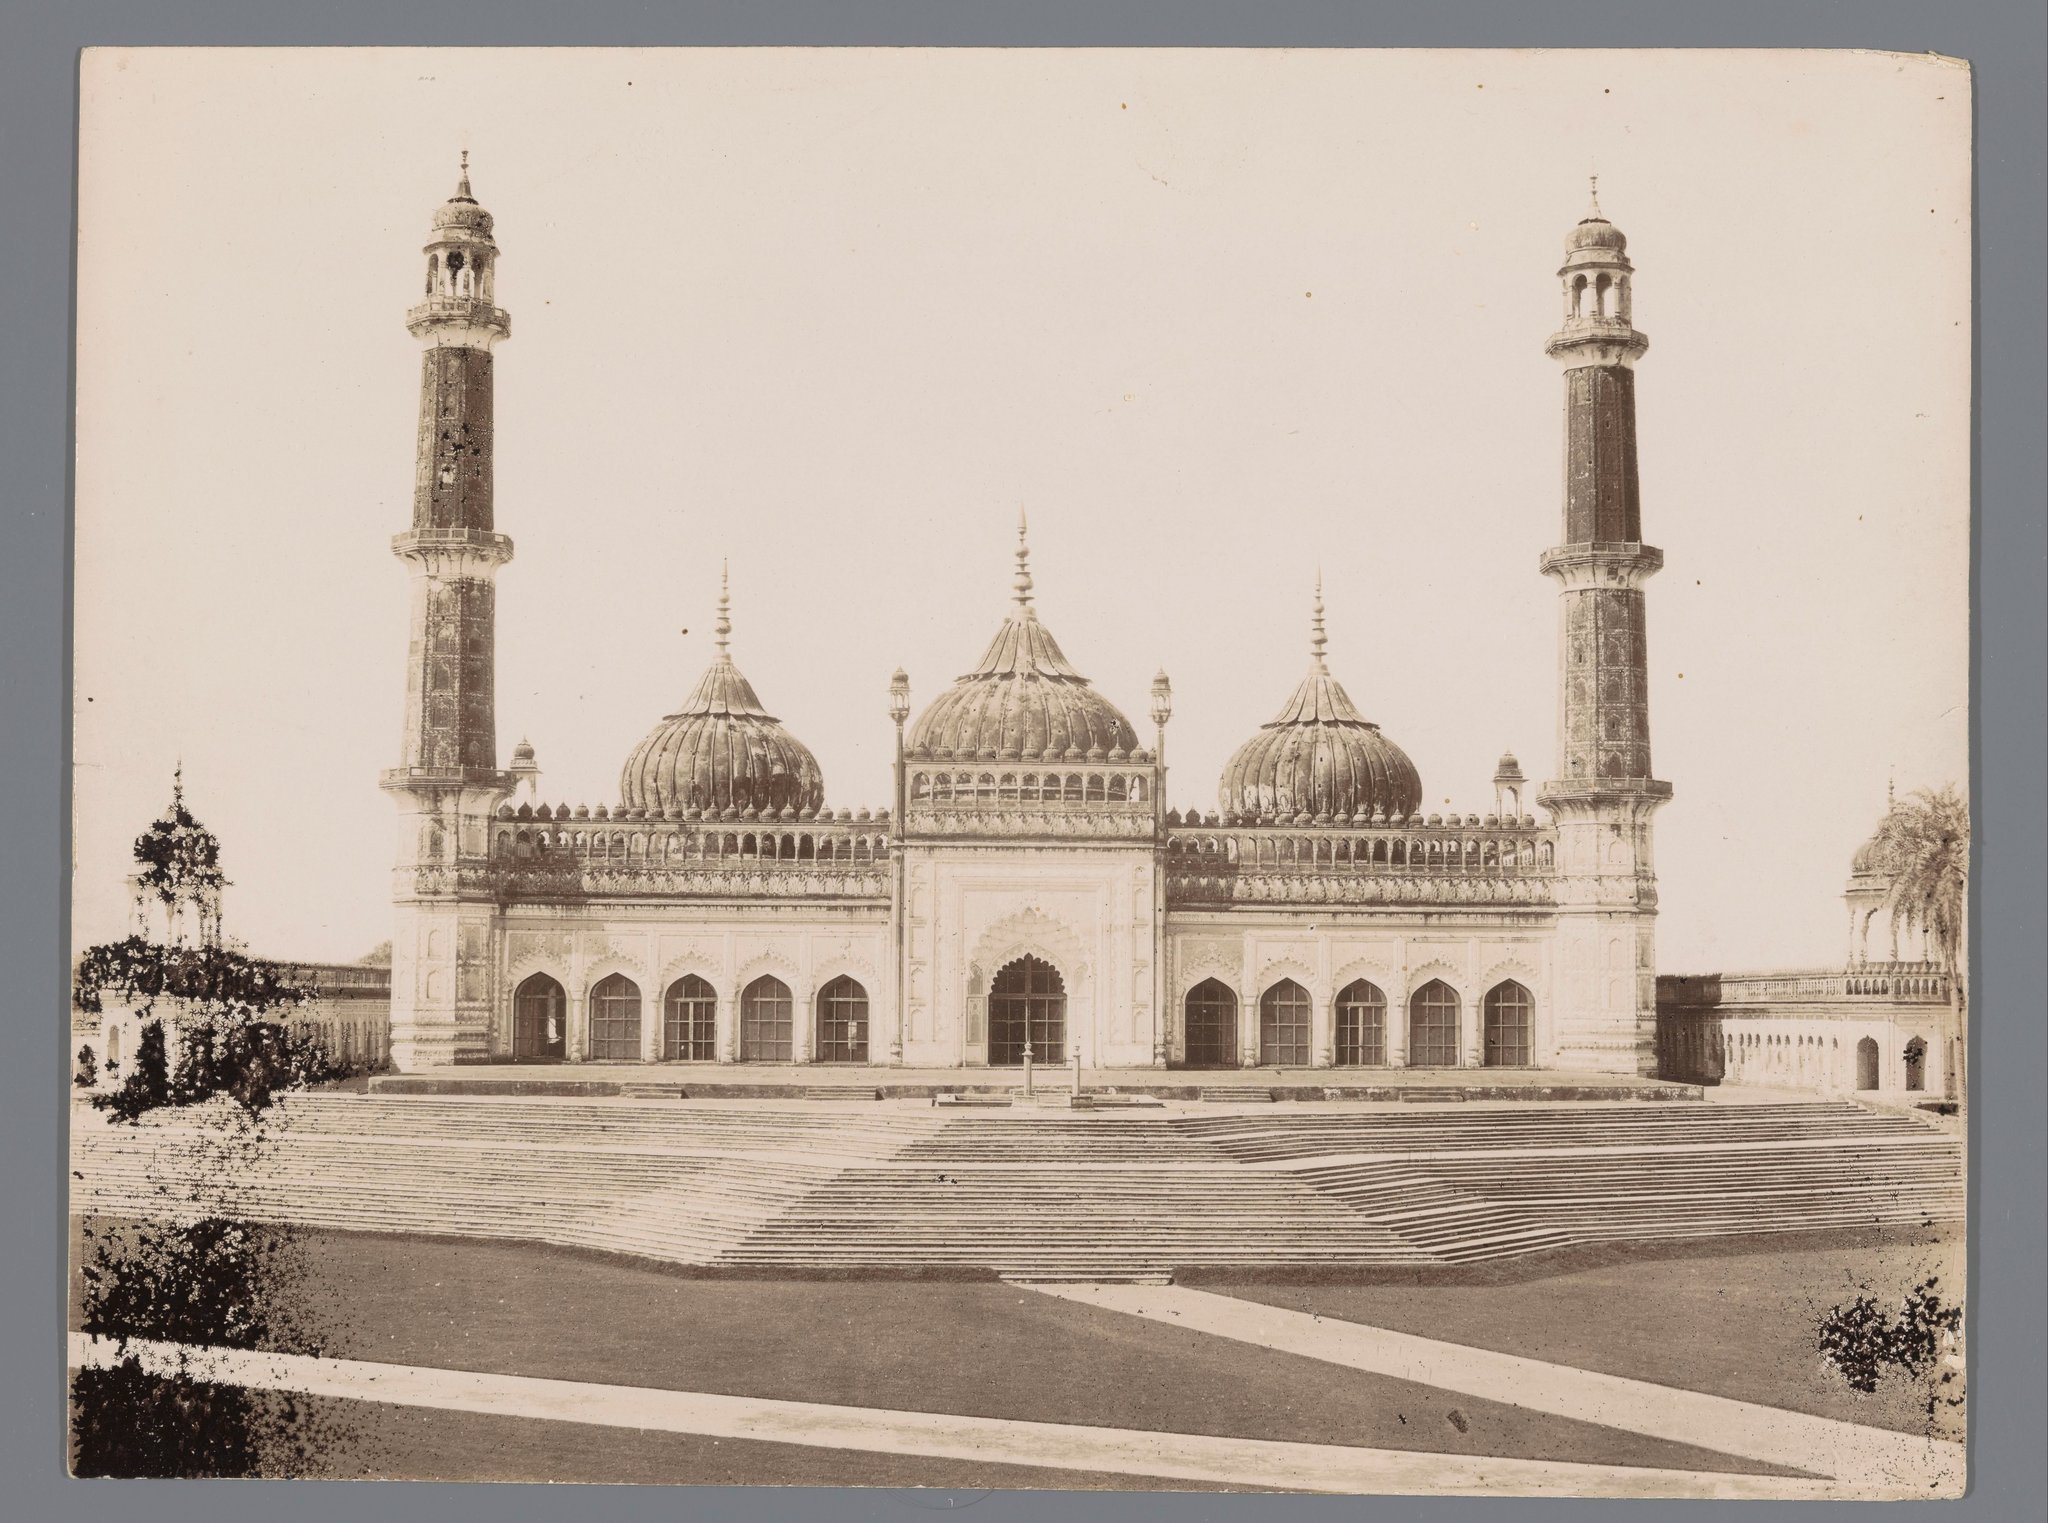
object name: photograph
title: View of the Asifi mosque in Lucknow, Uttar Pradesh, India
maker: Anonymous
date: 1890-1920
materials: paper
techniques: gelatin silver print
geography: lucknow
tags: temple, shrine ~ islam, mohammedanism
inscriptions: inscription: ‘Lucknow’